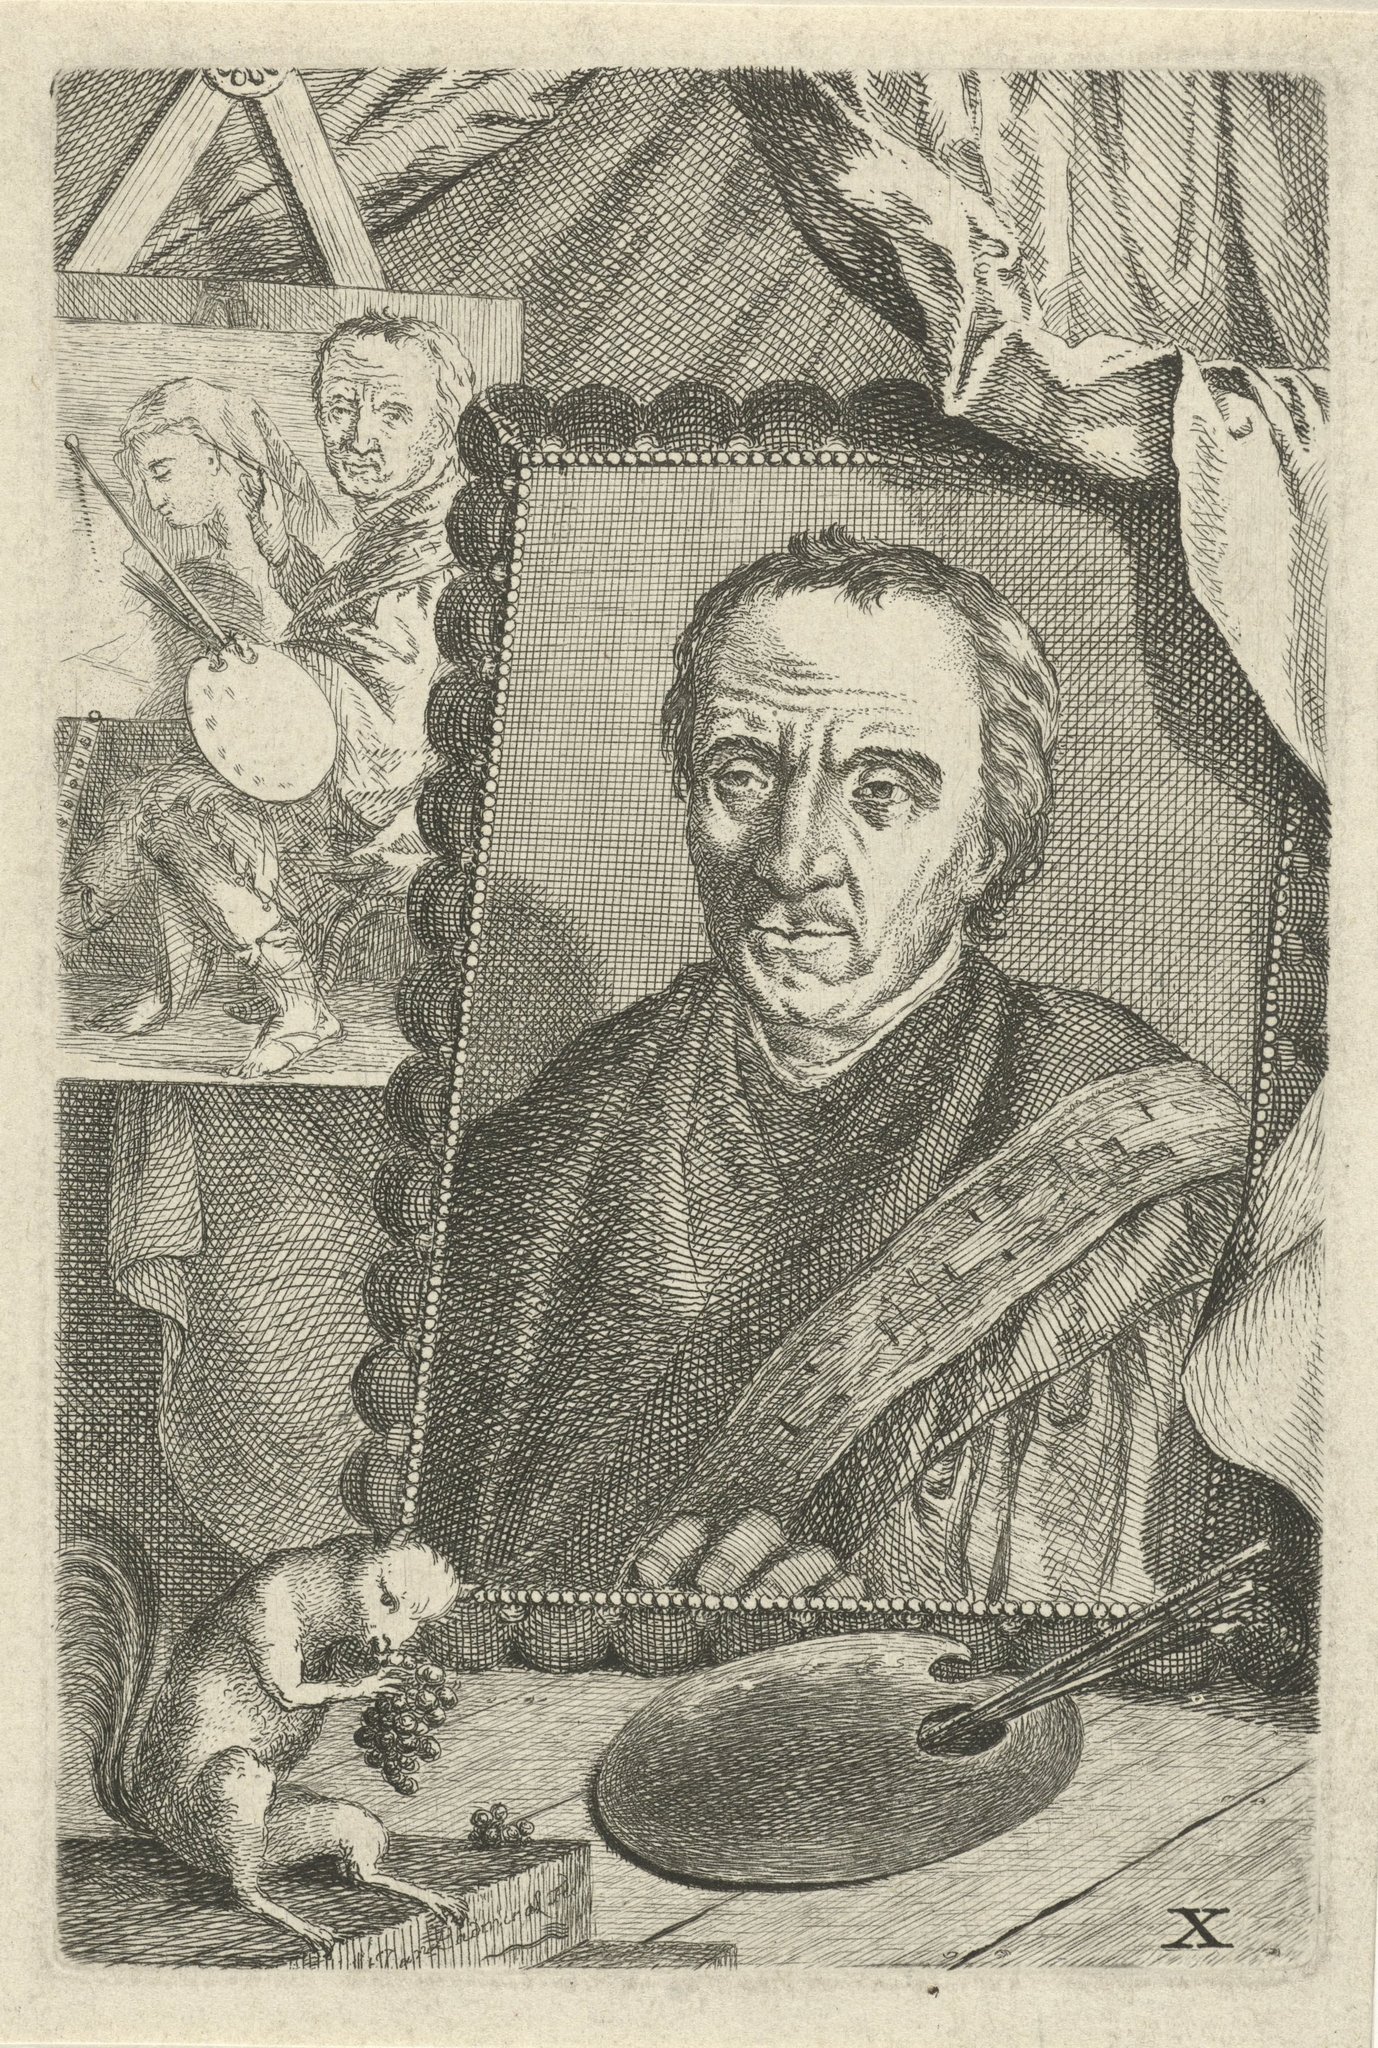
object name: print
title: Portret van Rijckaart Aarts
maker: jan l admiral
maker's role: draughtsman, print maker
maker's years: 1699-1773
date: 1764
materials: paper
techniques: etching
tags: painter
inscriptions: collector's mark: Lugt 2228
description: Prent opgenomen in: Mander, Karel van; Jongh, Jacobus de (vert.). Het leven der doorluchtige Nederlandsche en eenige Hoogduitsche schilders. Amsterdam: Steven van Esveldt, 1764.